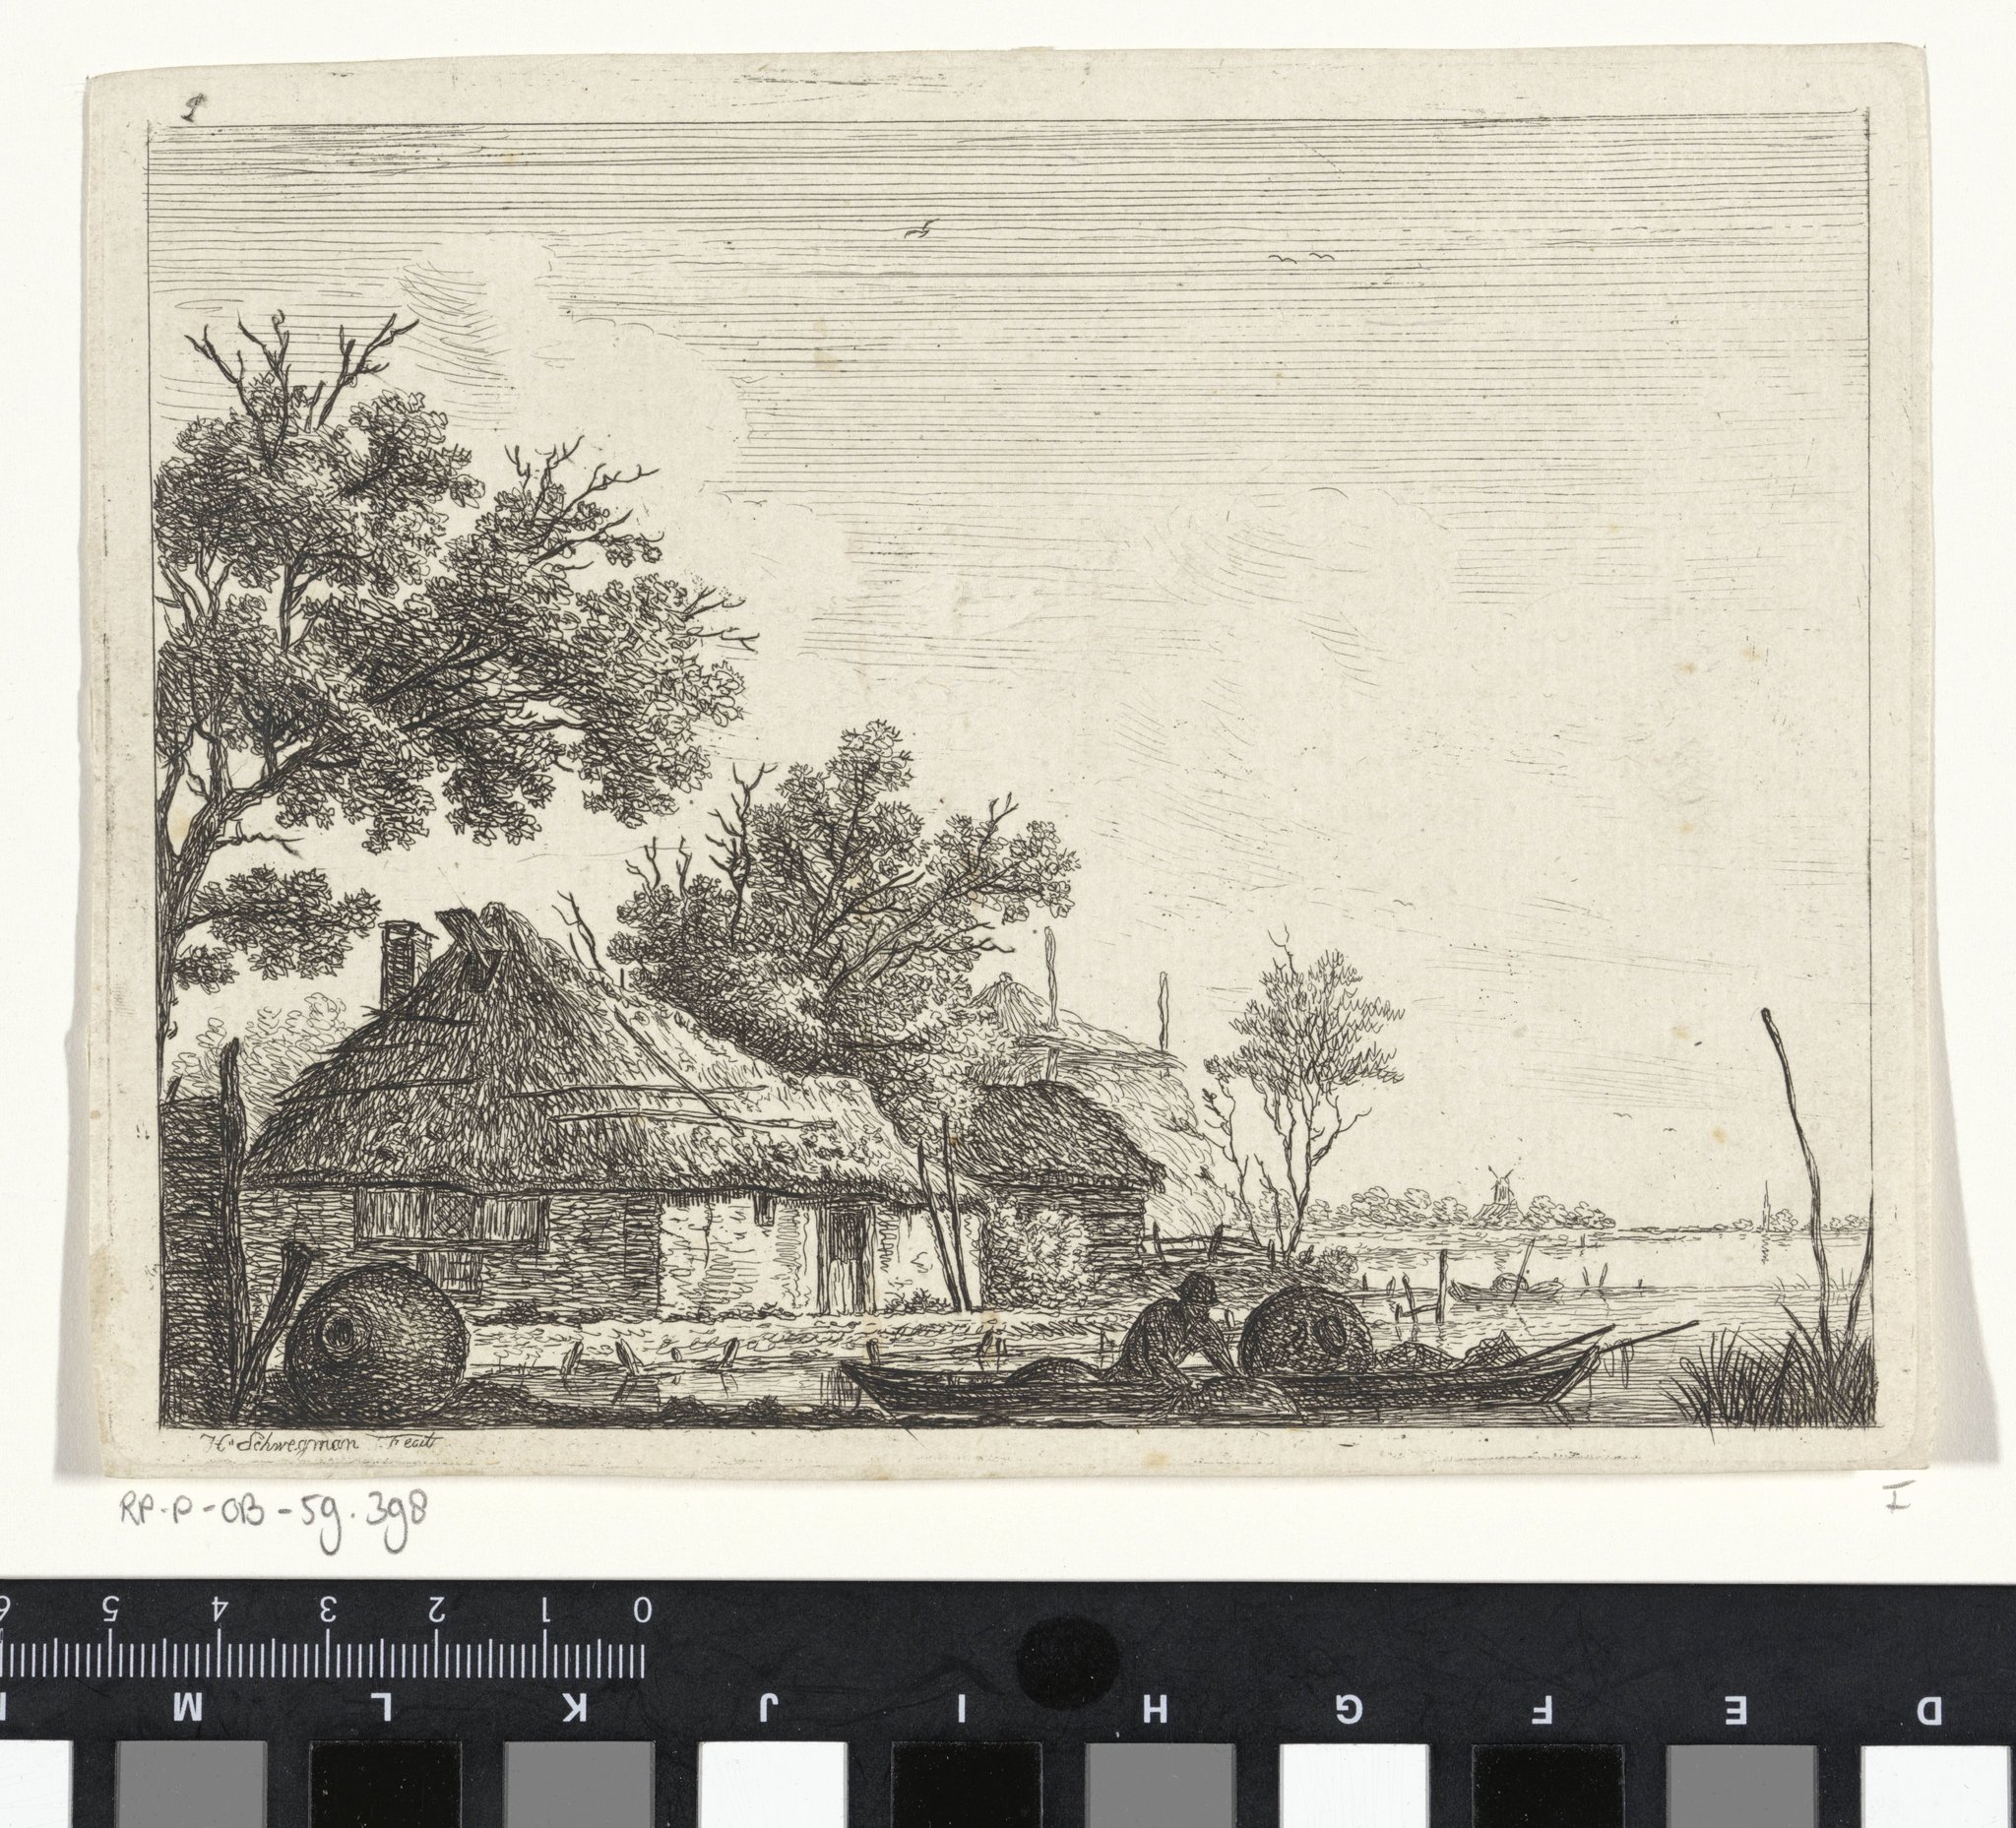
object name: print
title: Landschap met boerderij en visser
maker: hendrik schwegman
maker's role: draughtsman, print maker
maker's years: 1761-1816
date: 1786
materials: paper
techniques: engraving, etching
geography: haarlem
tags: water course, farm or solitary house in landscape, fisherman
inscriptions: collector's mark: Lugt 2228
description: Landschap met een boerderij en hooiberg links. Op de voorgrond op het water een visser met fuiken in een boot.